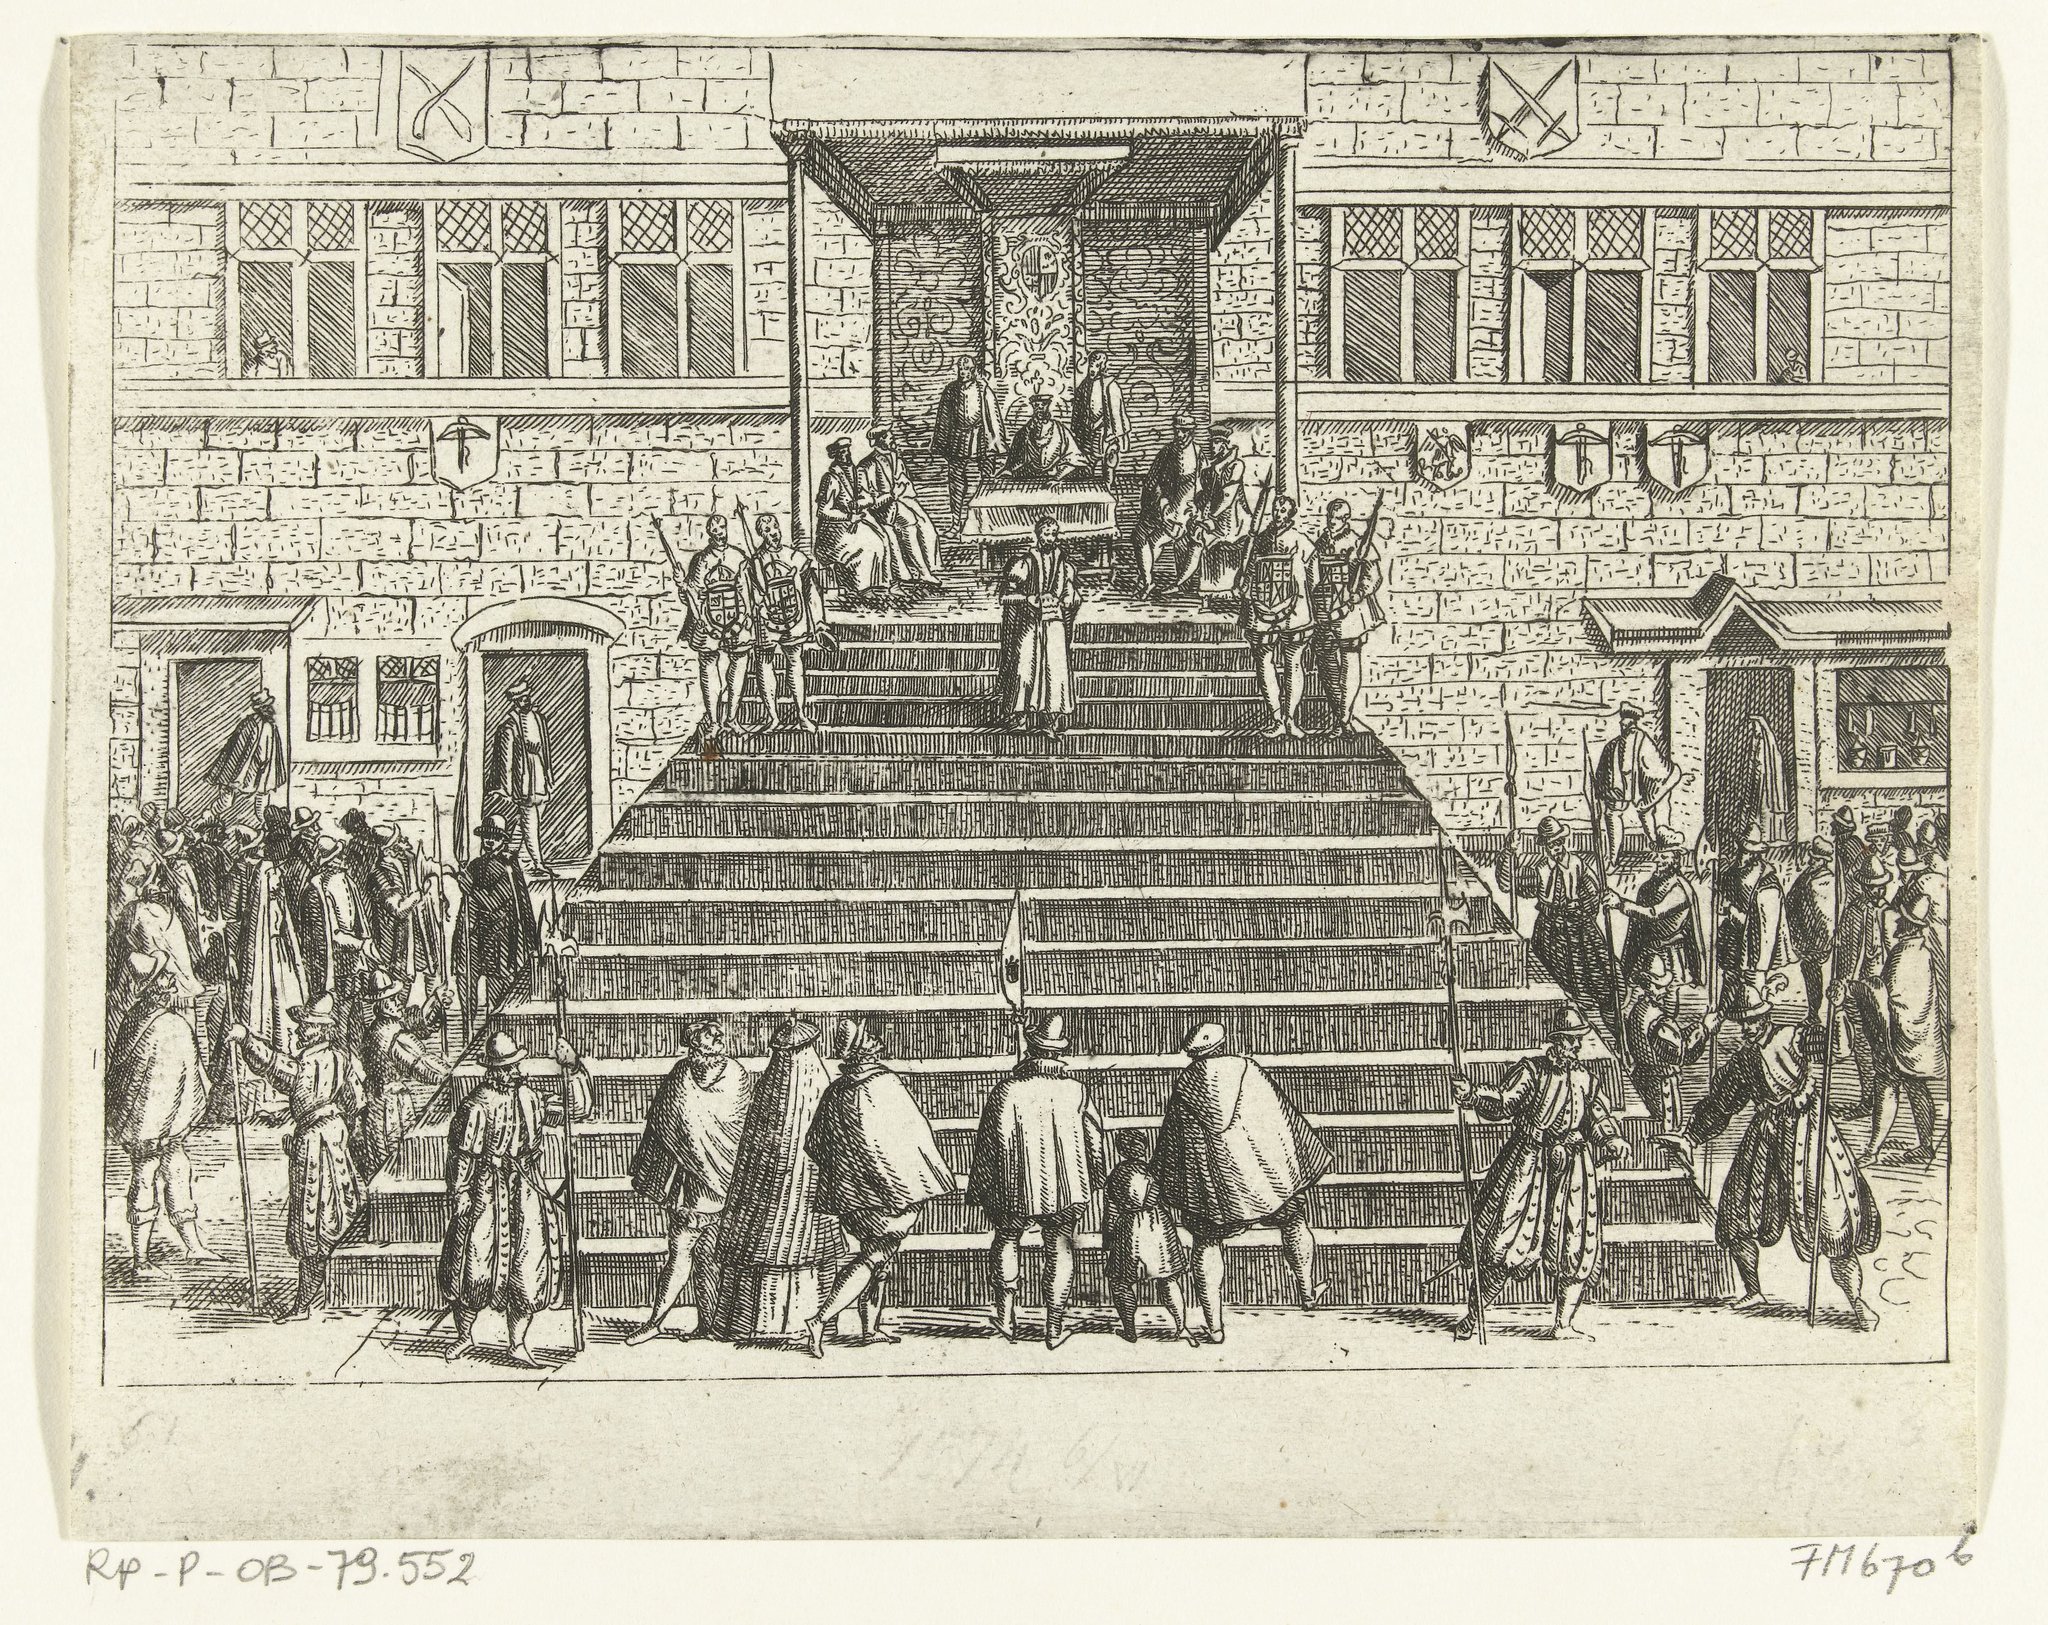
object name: print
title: Afkondiging van het tweede Generaal Pardon, 1574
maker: Anonymous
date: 1613-1615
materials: paper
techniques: etching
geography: northern netherlands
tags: brussels, luis de zúñiga y requesens, granting mercy; free pardon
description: Afkondiging van het tweede Generaal Pardon, 5 april 1574. Voor het Broodhuis te Brussel laat Requesens het Generaal Pardon voorlezen. Zonder onderschrift of nummer en onbedrukt op achterzijde.